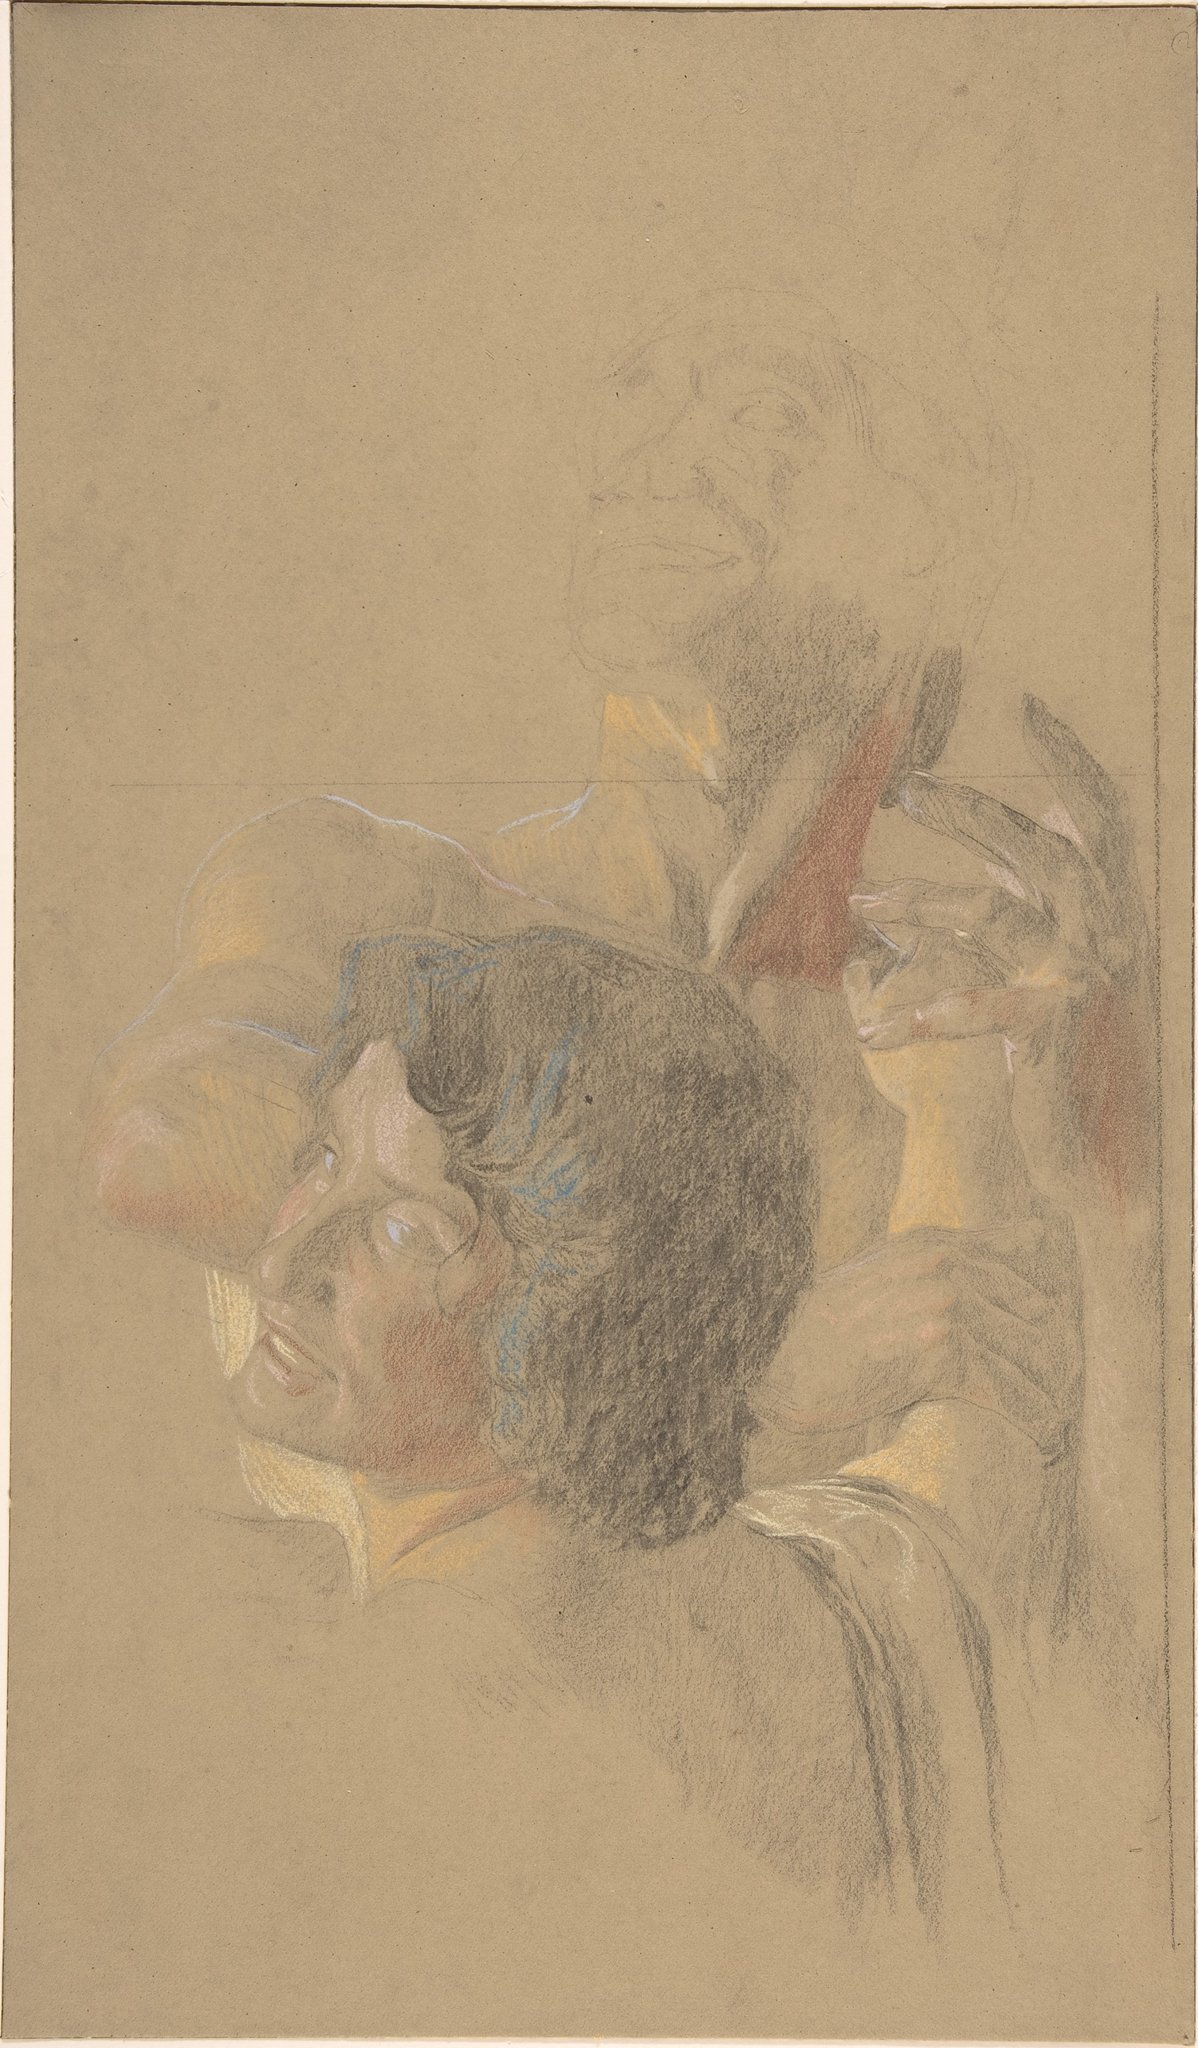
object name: drawing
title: A male and a female figures (study for 'Golgotha')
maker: otto greiner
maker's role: artist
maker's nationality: german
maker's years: 1869-1916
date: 1867-1933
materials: chalk, paper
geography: germany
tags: women